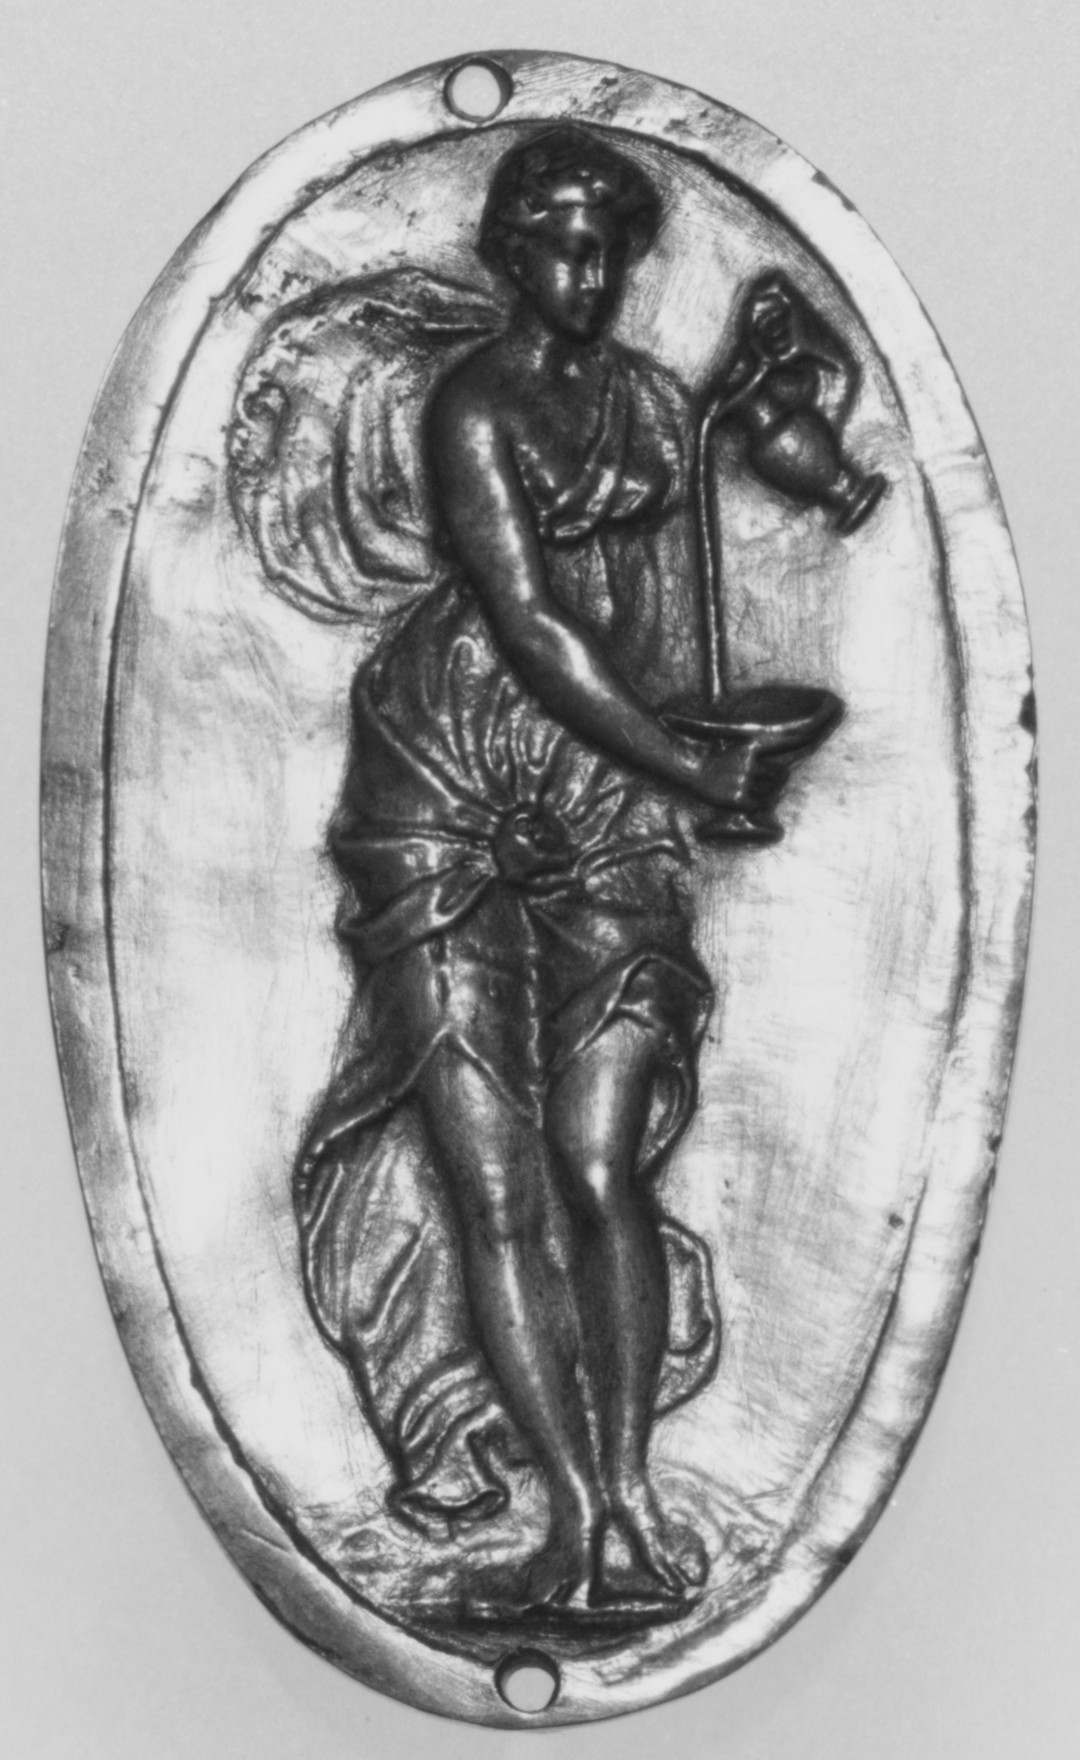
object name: plaquette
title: Temperance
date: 1867-1900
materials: bronze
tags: human figures